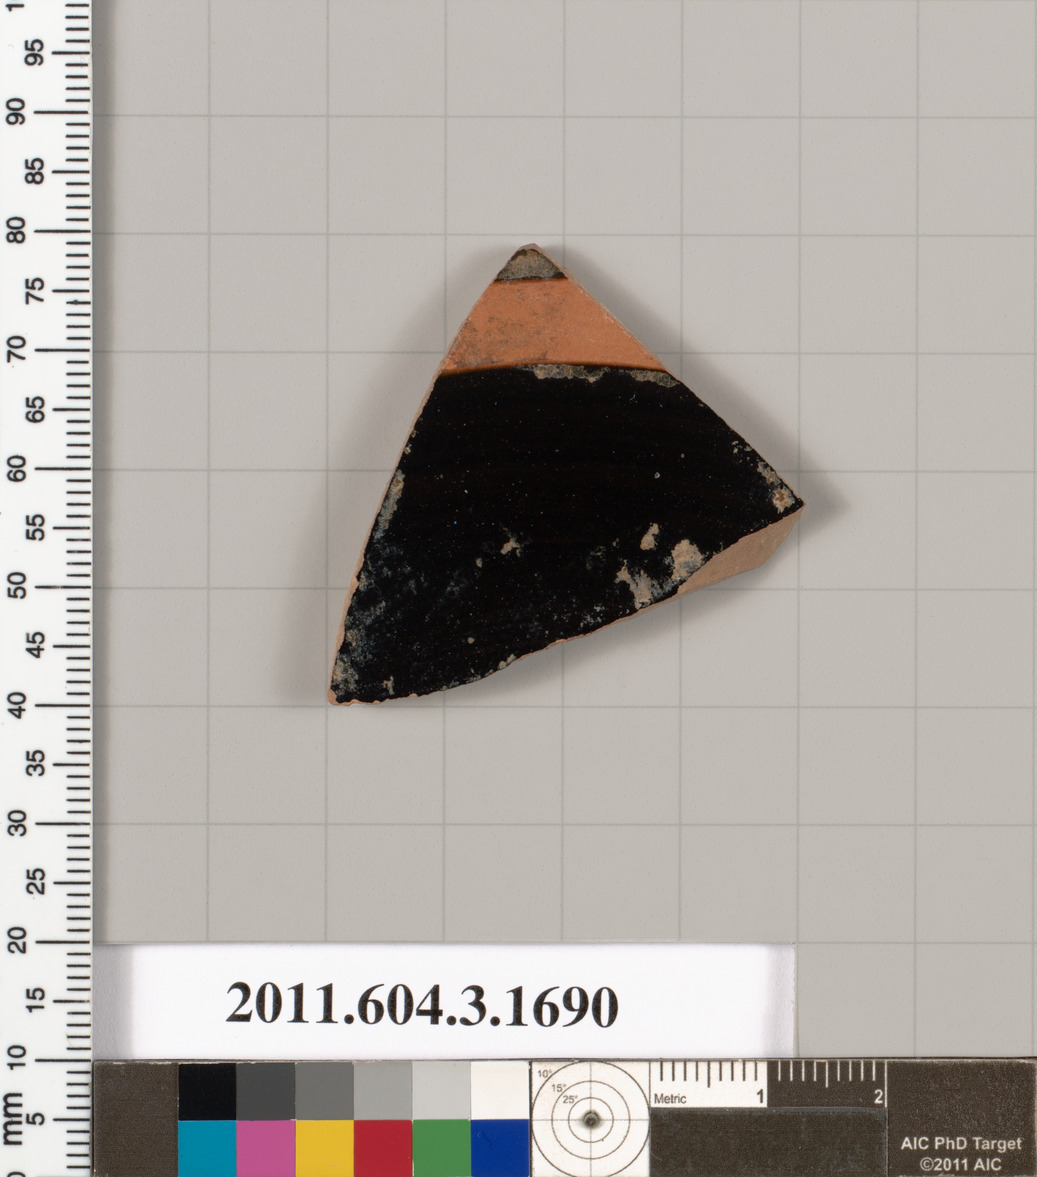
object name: kylix fragment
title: Terracotta fragment of a kylix: Band or lip cup (drinking cup)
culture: greek, attic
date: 550-526 BCE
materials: terracotta